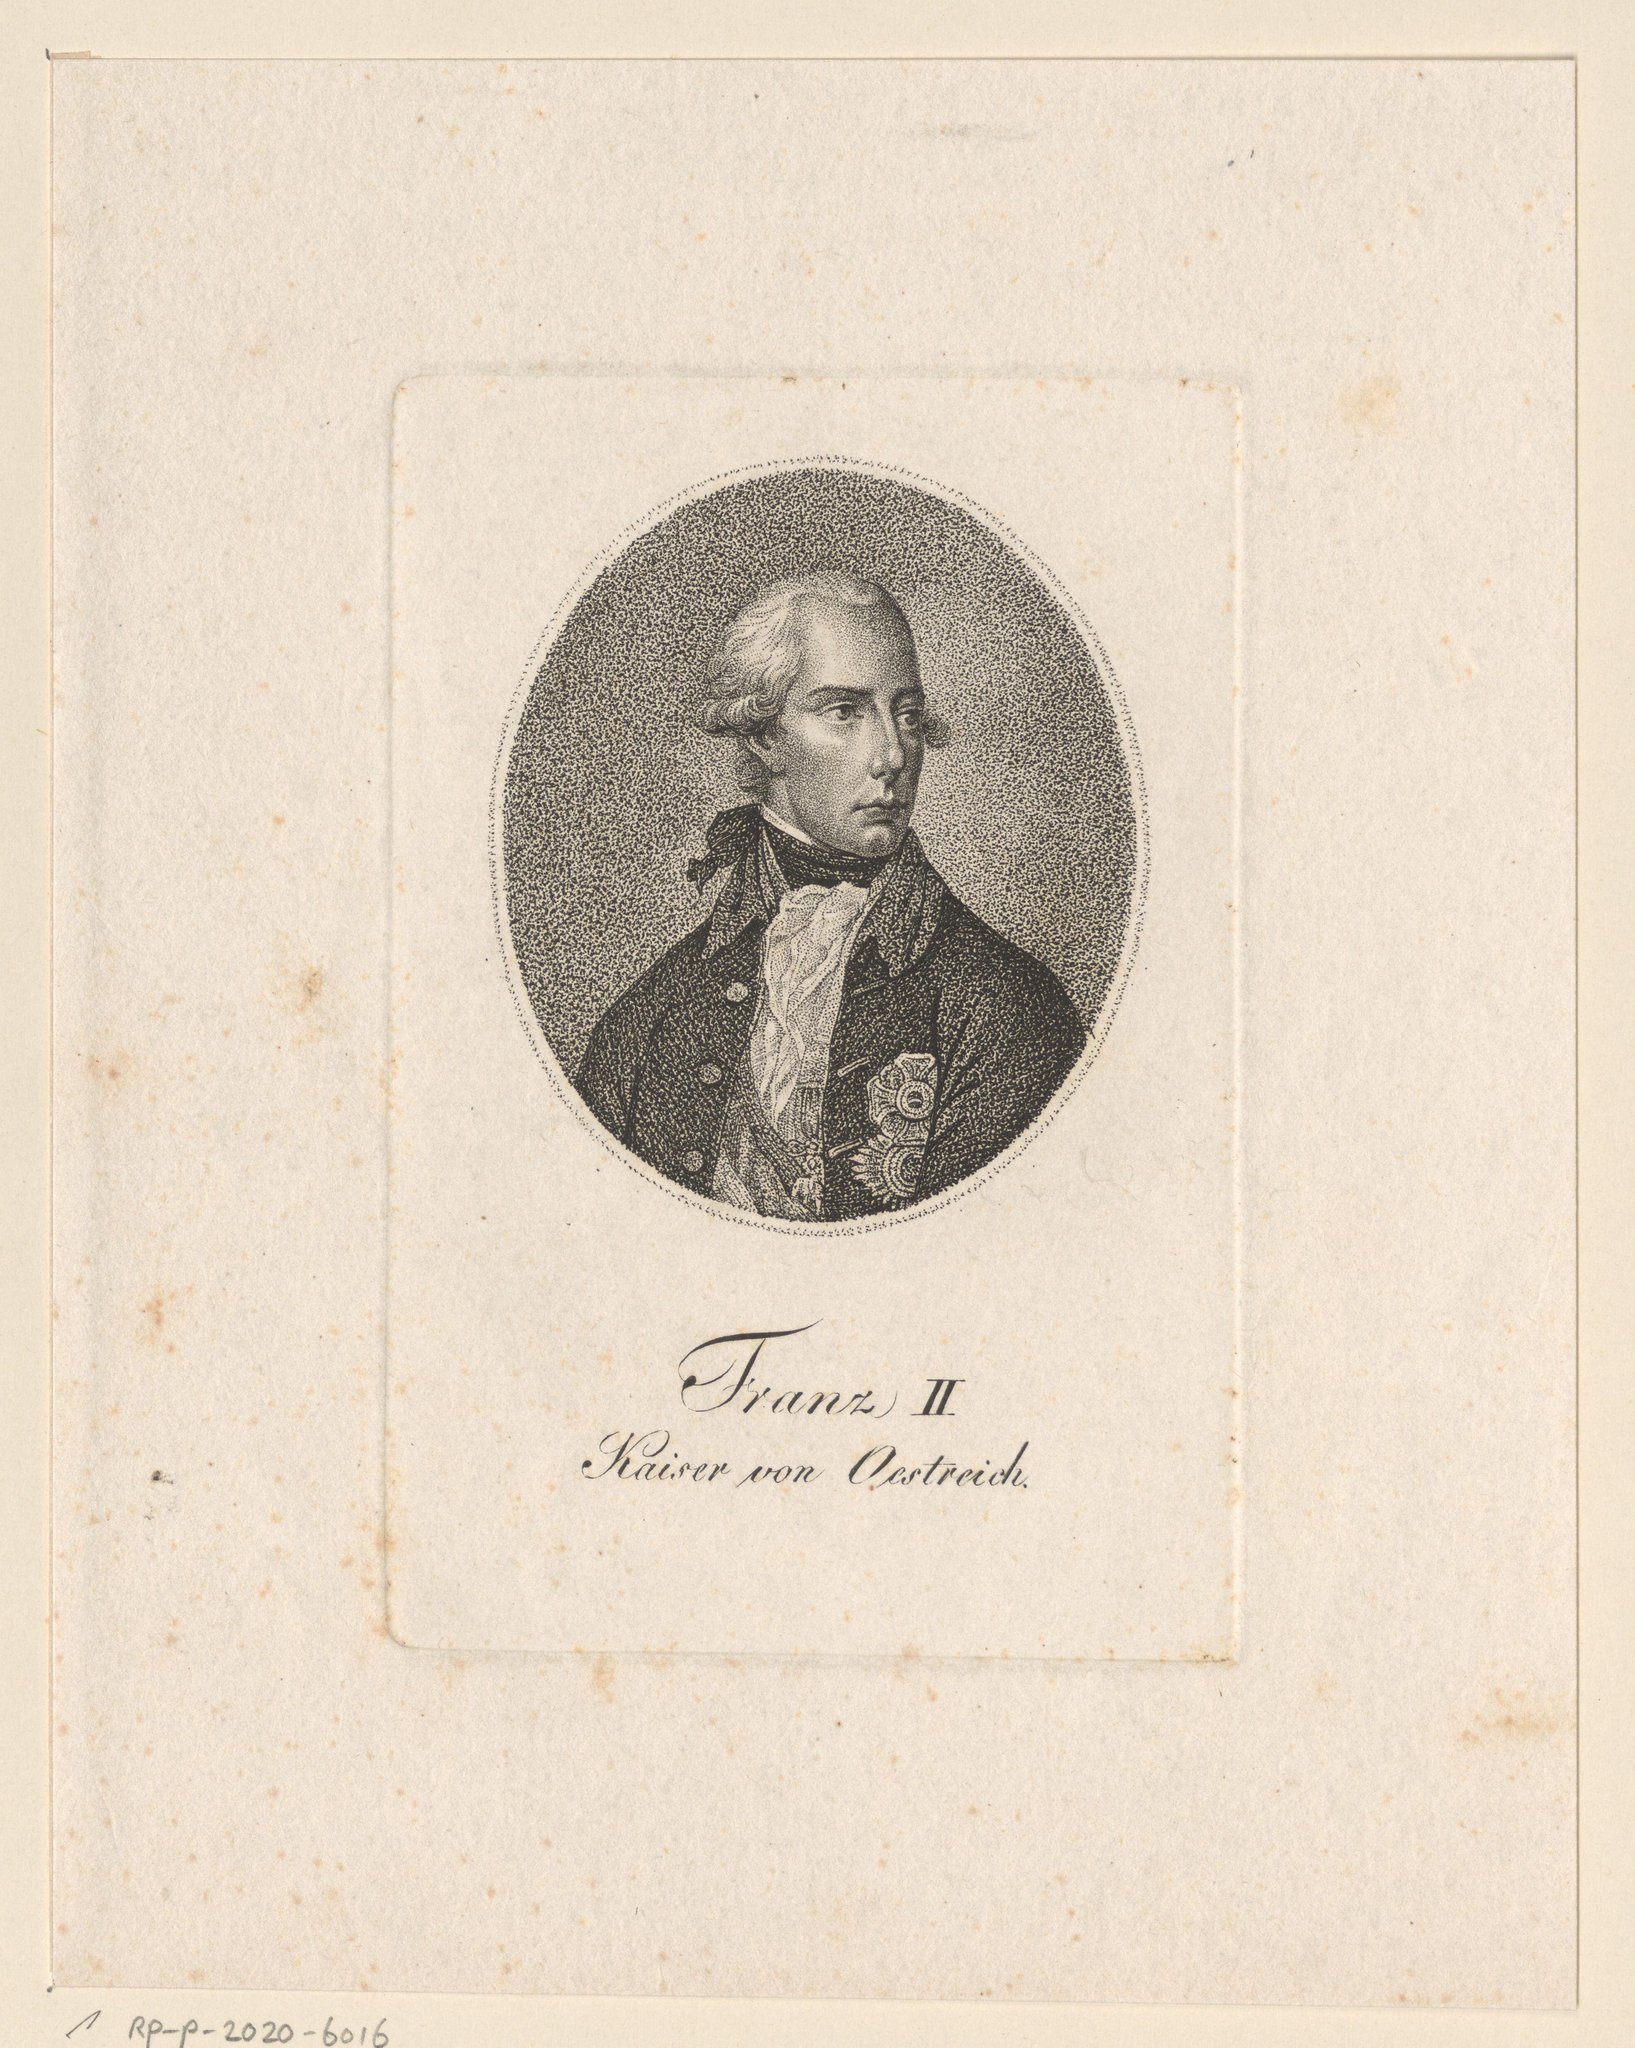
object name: print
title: Portret van Frans I, keizer van Oostenrijk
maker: Anonymous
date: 1804-1835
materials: paper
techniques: stippling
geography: germany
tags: frans ii (rooms-duits keizer), historical persons, emperor